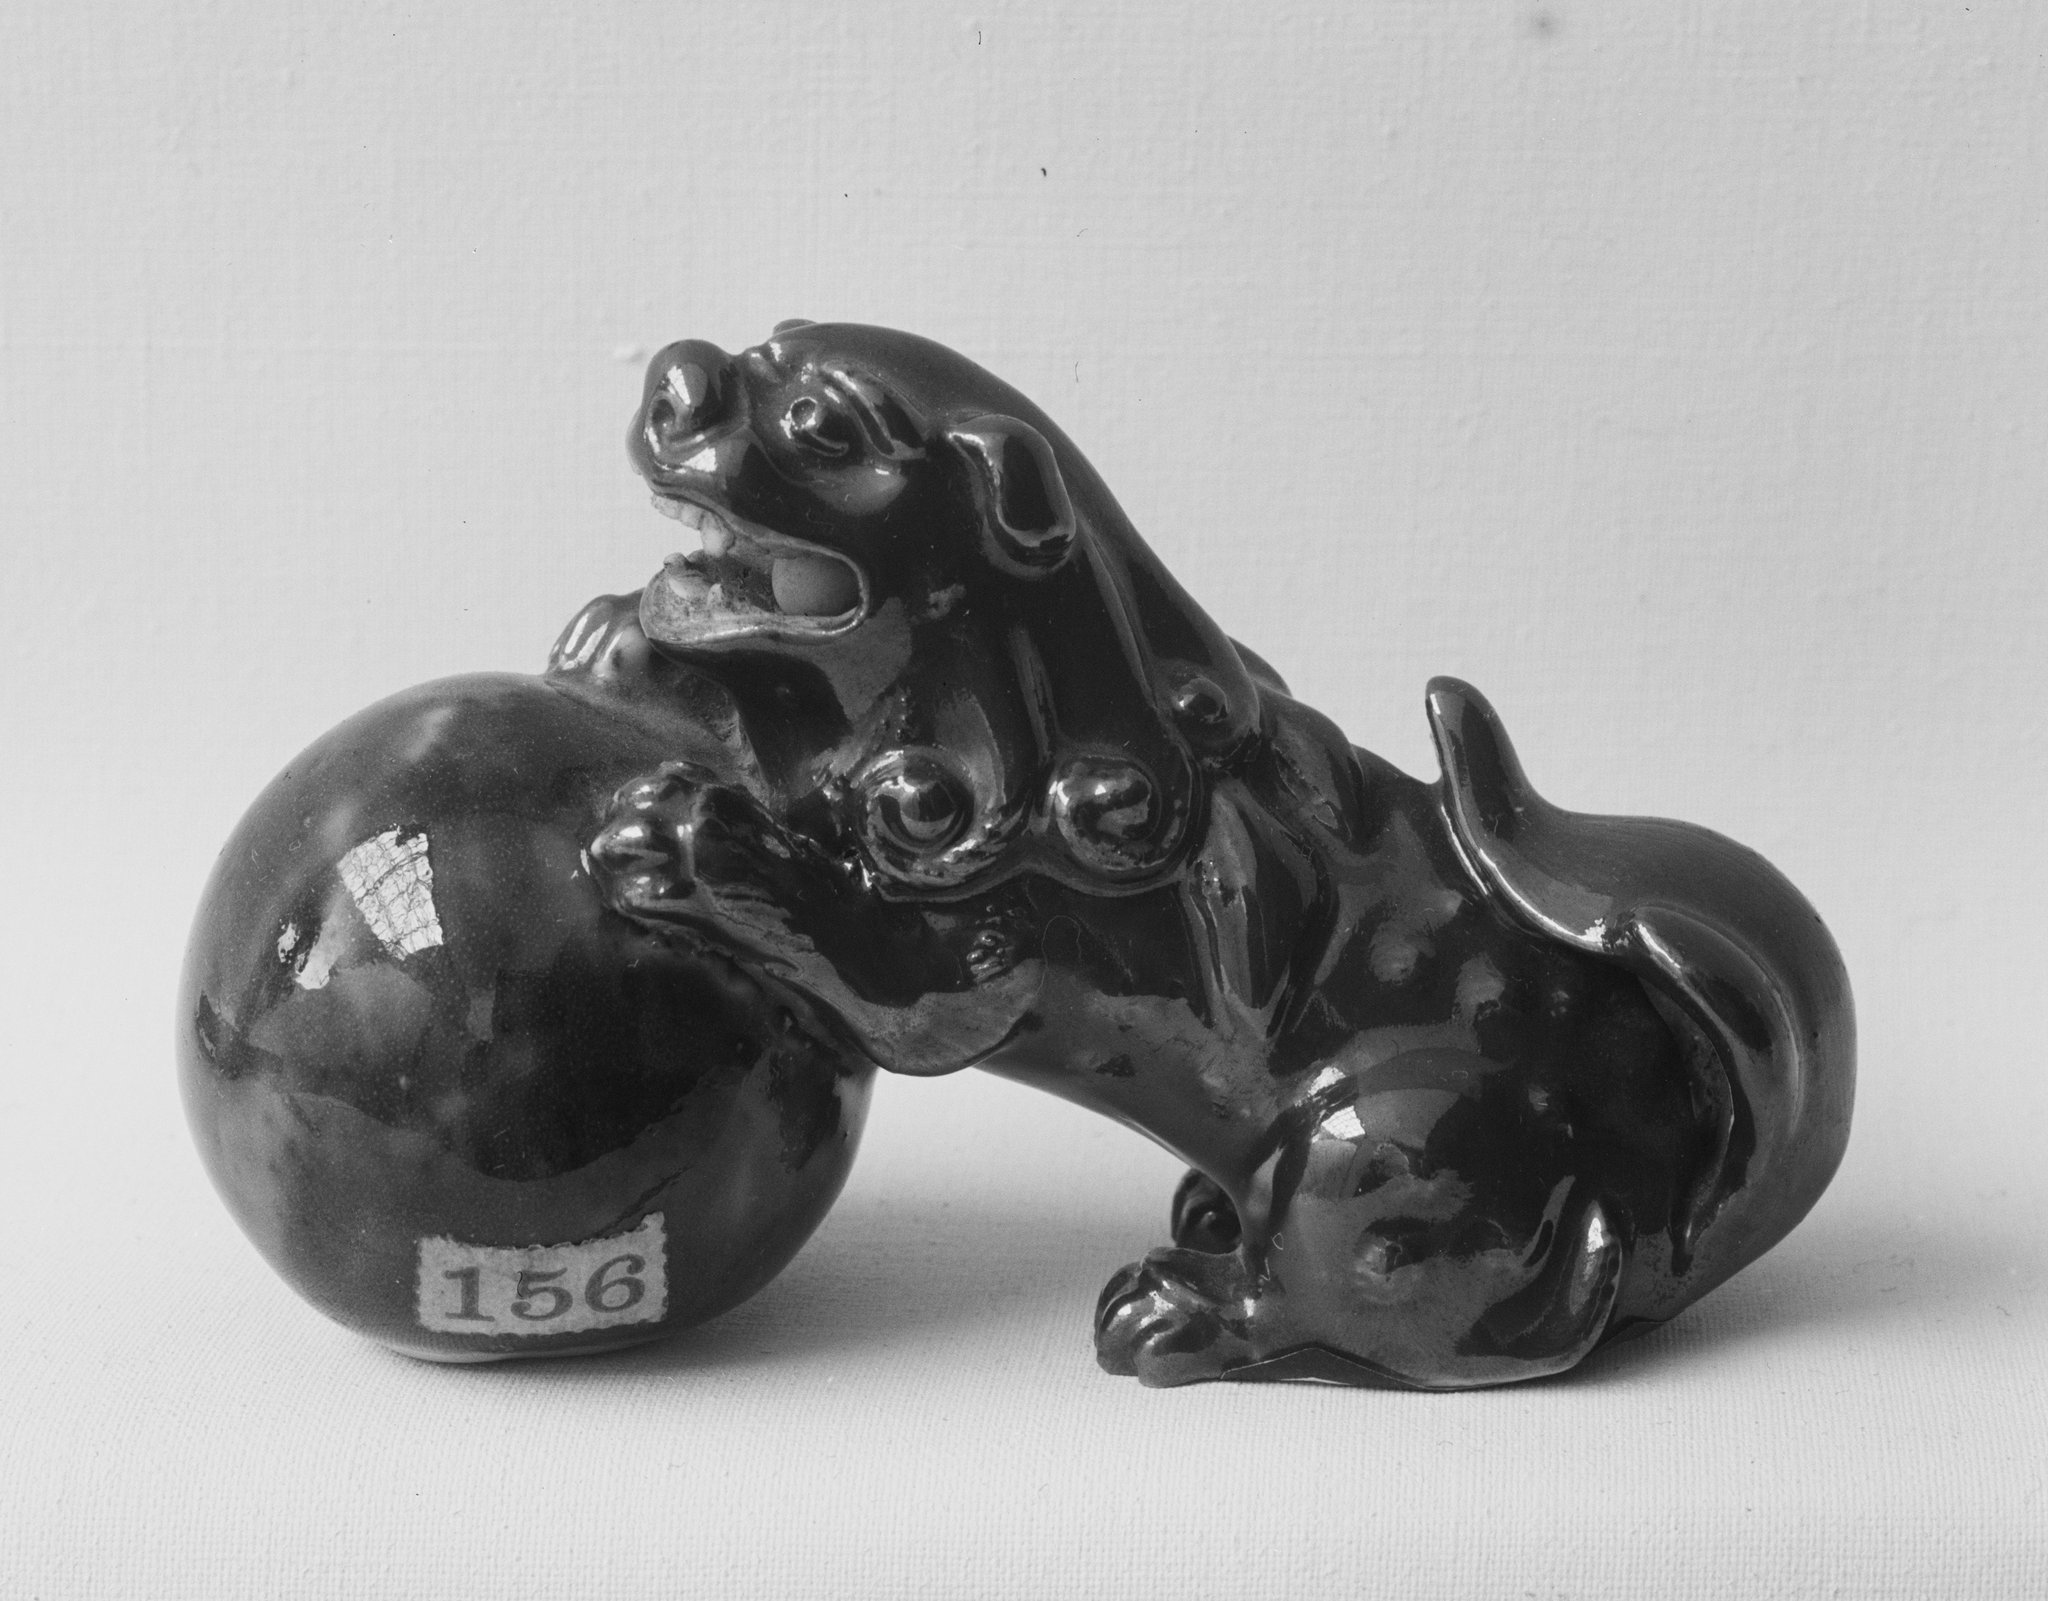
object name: ornament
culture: japanese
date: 1801-1900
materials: porcelain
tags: animals